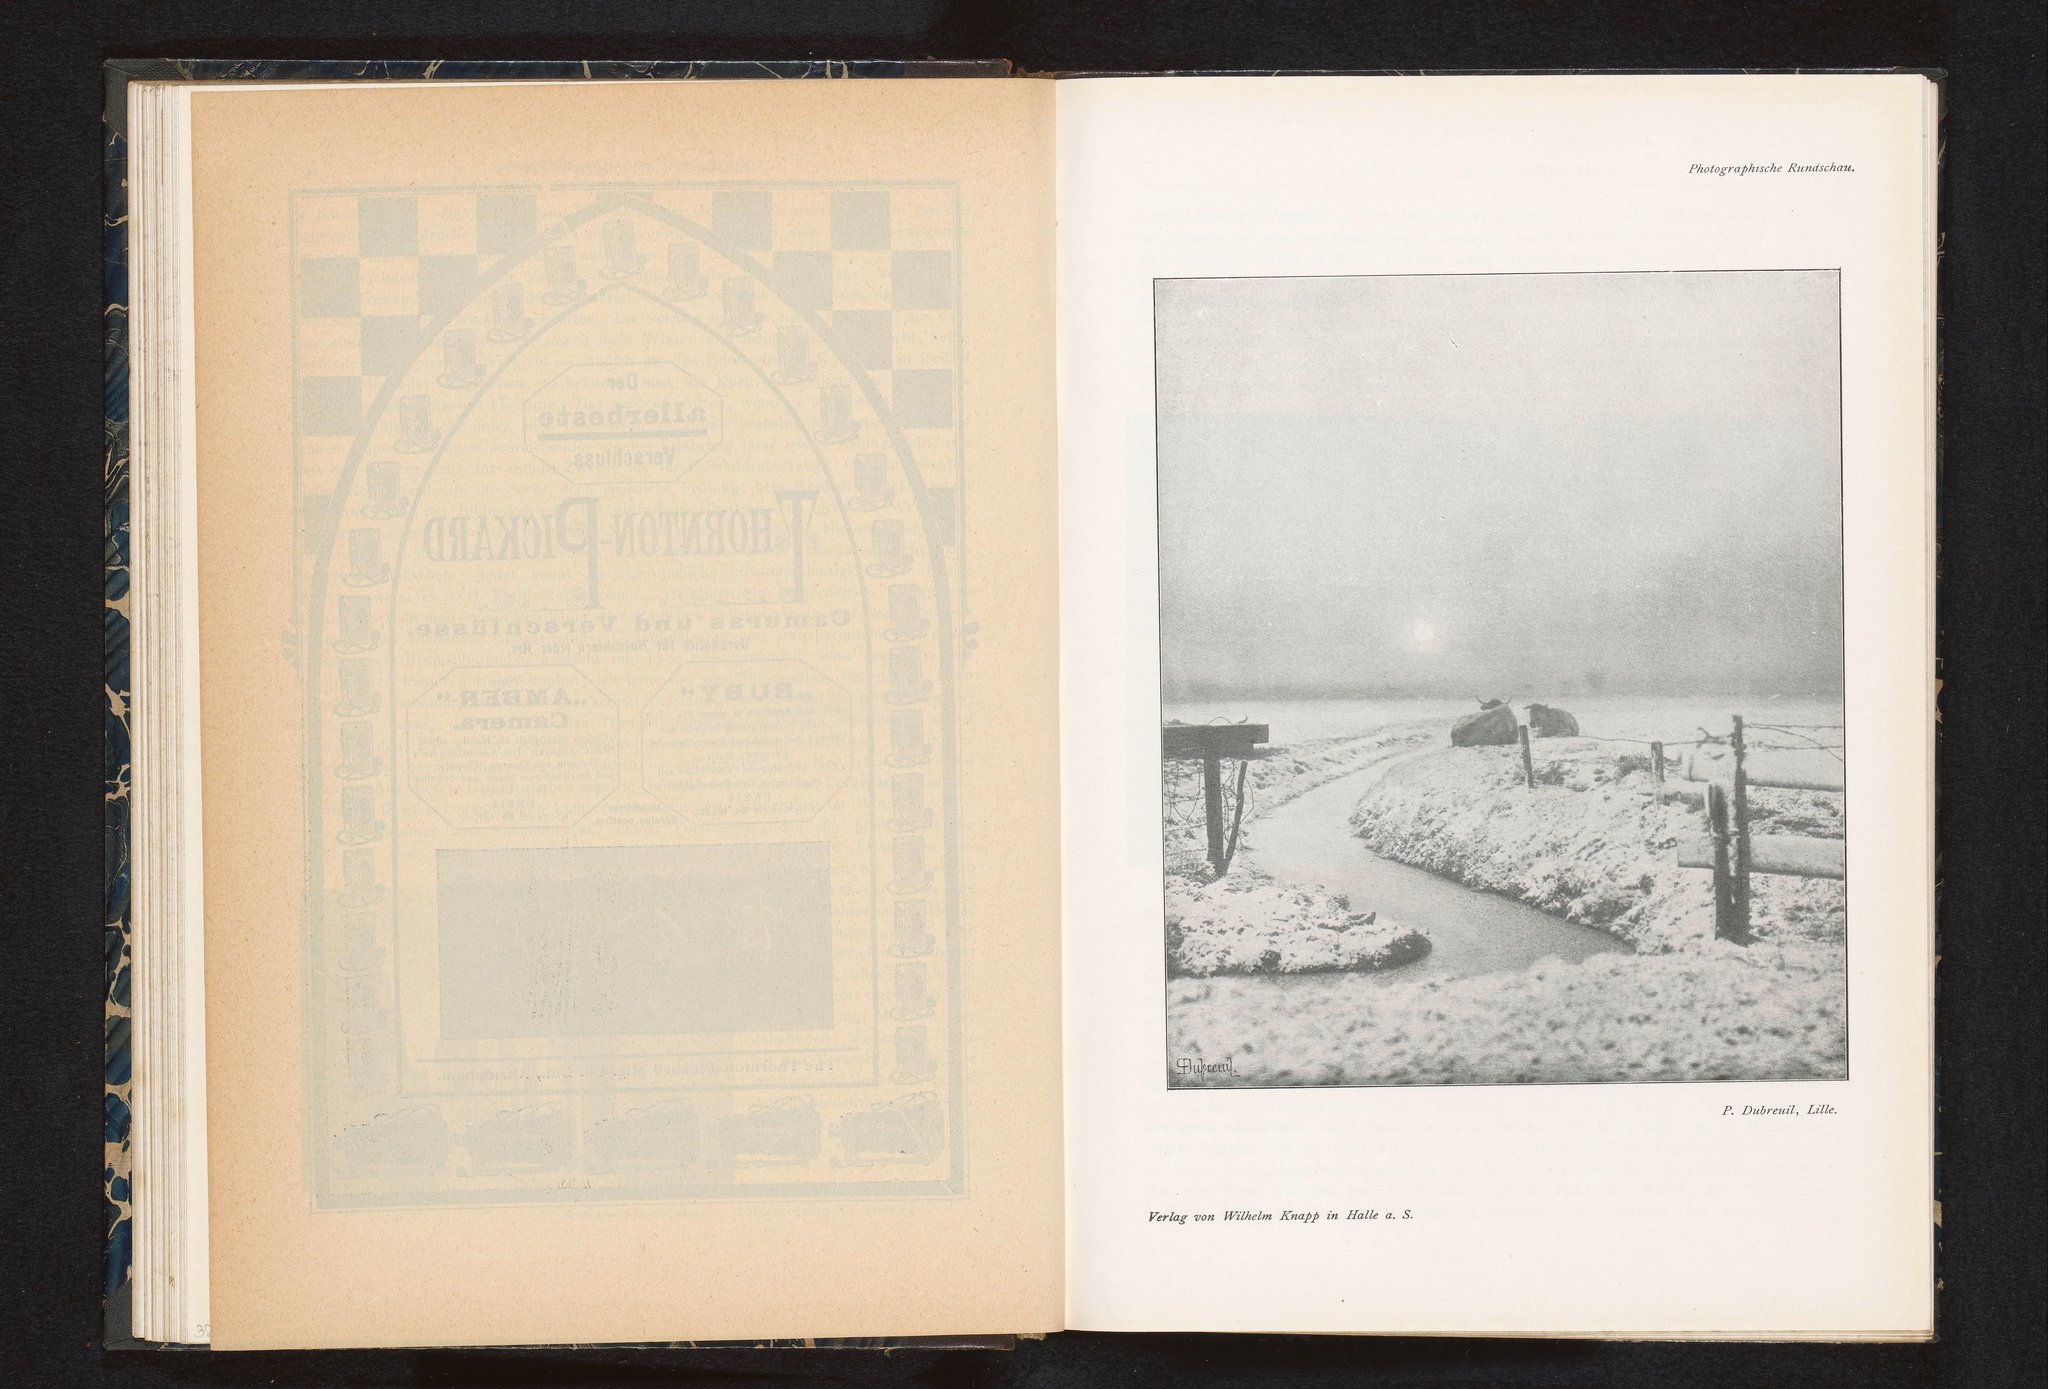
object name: page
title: Twee liggende koeien in een besneeuwde weide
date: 1896-1901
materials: paper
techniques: autotype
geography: halle an der saale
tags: cow, landscapes, snow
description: Prent op tweede ongenummerde pagina na pagina 40.